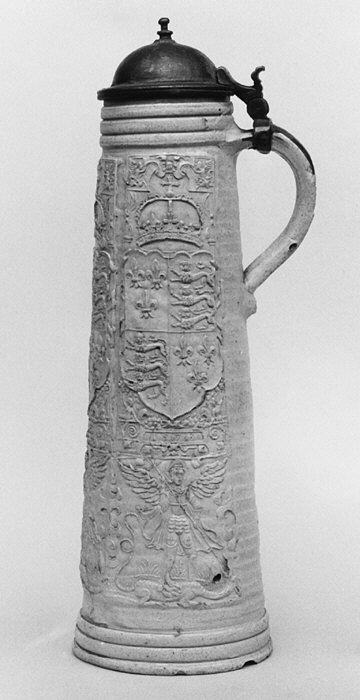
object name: flagon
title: Flagon (Schnelle)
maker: hans hilgers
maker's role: maker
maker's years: 1565-1595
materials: pewter, stoneware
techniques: salt glaze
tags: coat of arms